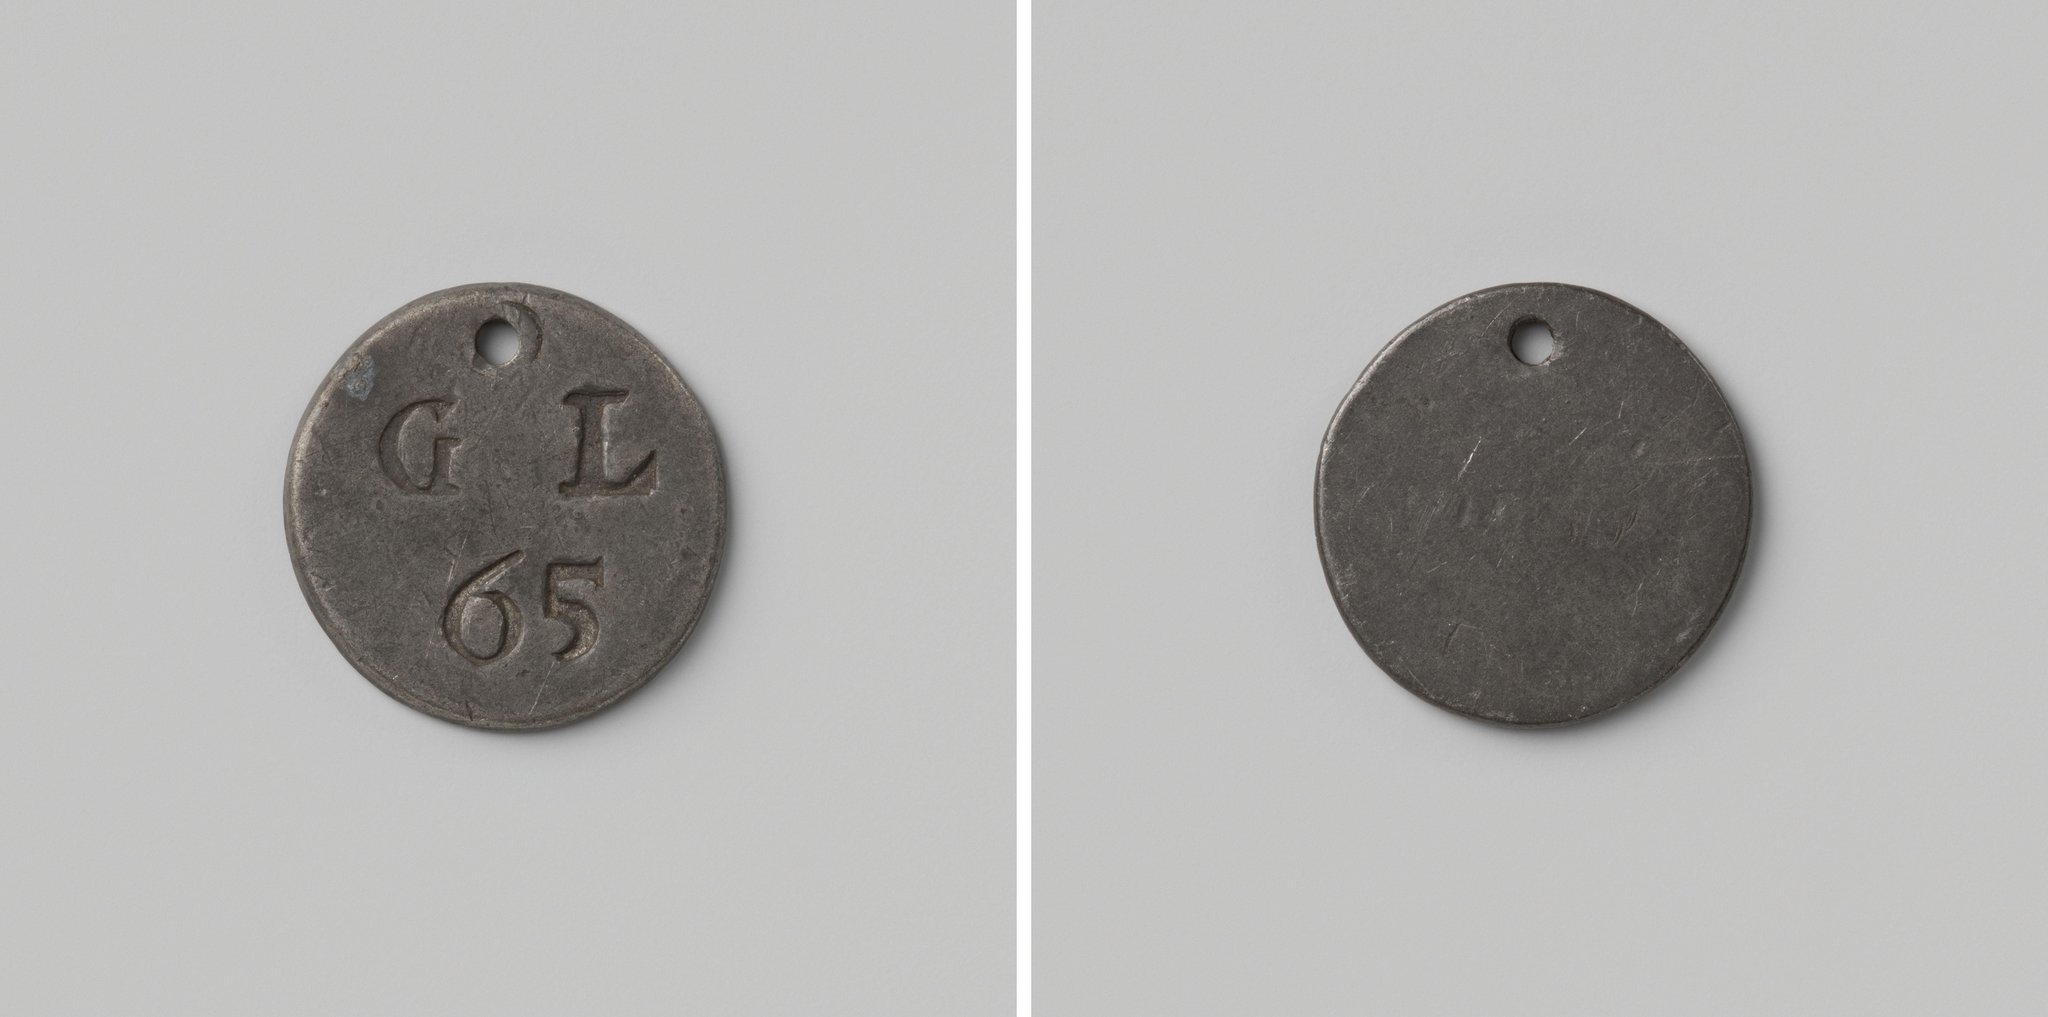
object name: medal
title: Penning met opschrift GL 65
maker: Anonymous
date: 1650-1850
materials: tin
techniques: striking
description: Eenzijdige tinnen penning met gat erin. Voorzijde: opschrift GL boven cijfer 65. Keerzijde: blanco